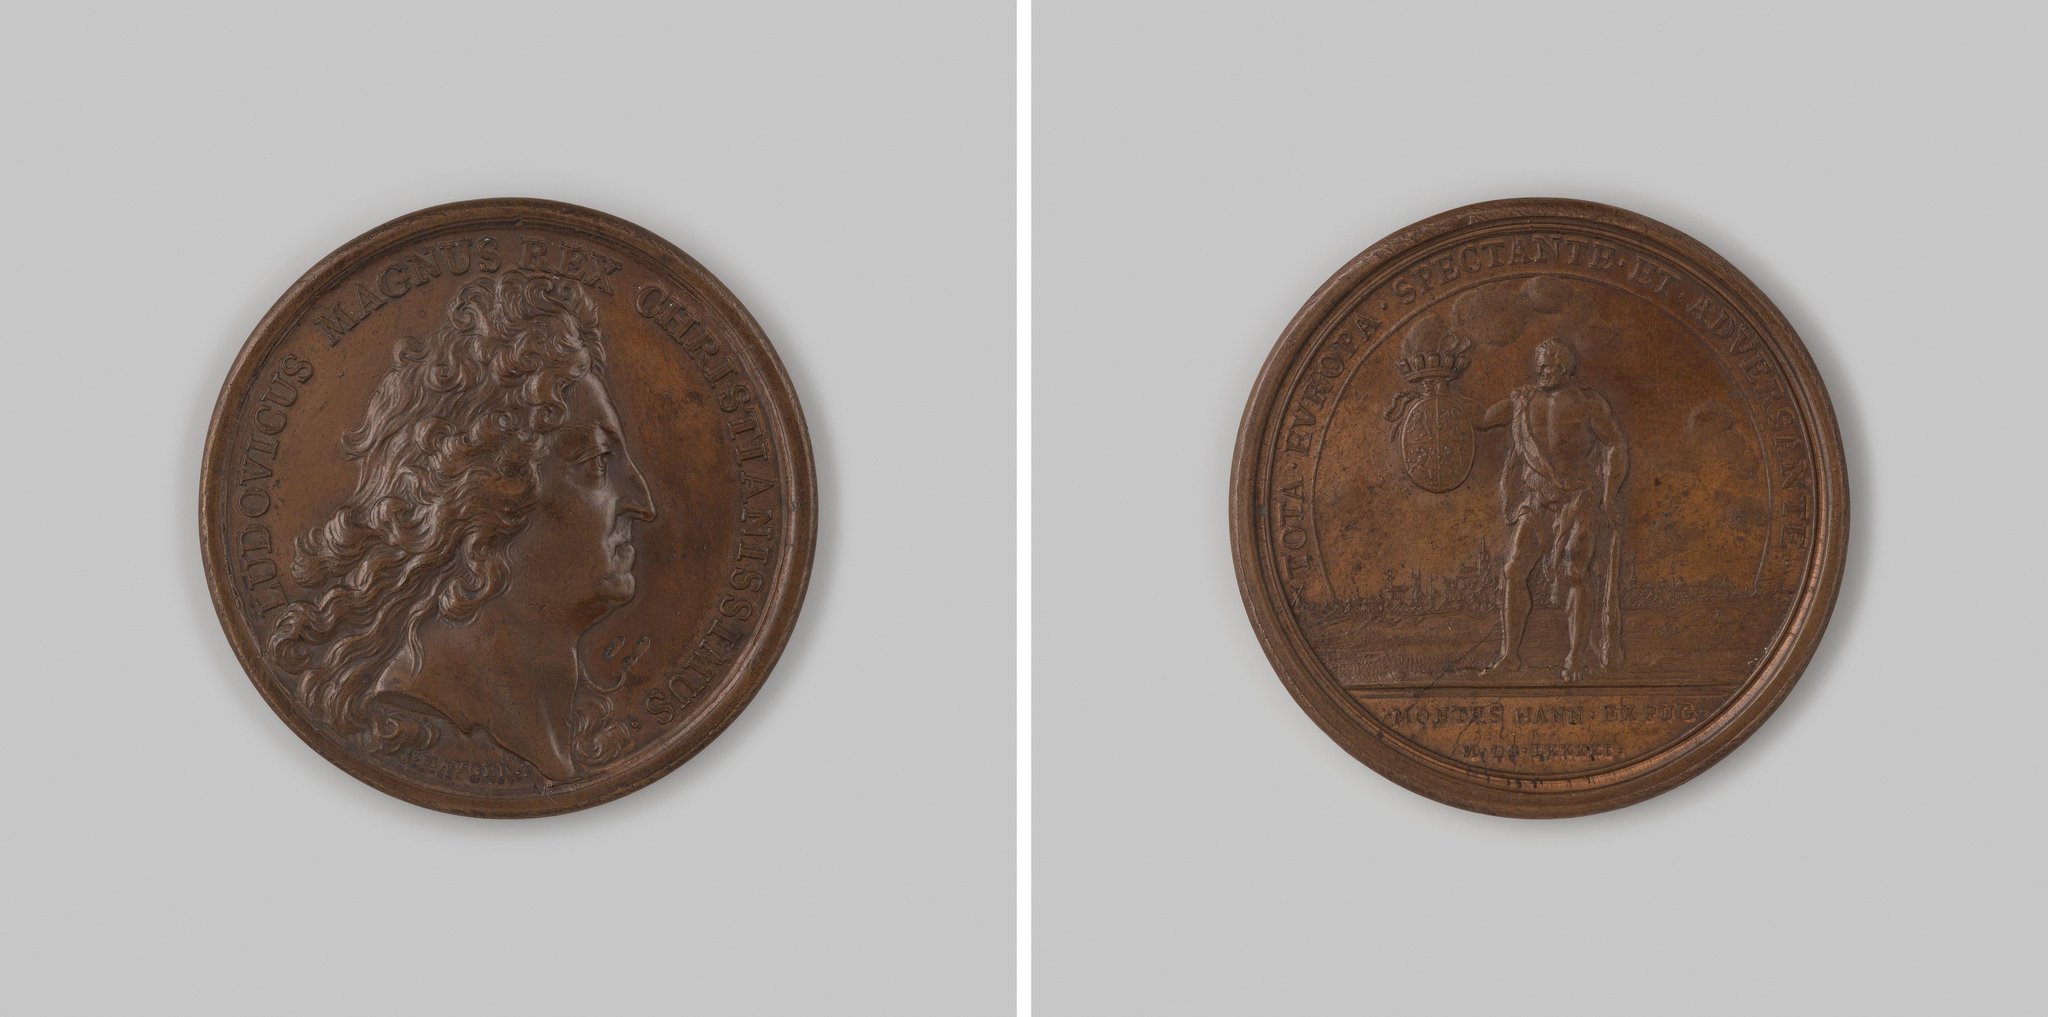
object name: history medal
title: Bergen in Henegouwen ingenomen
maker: jean mauger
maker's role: medailleur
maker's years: 1648-1722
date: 1699-1702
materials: bronze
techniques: striking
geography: paris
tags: lodewijk xiv (koning van frankrijk), henegouwen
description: Bronzen penning. Voorzijde: borststuk man binnen omschrift. Keerzijde: Hercules met knots houdt gekroond wapenschild van Bergen omhoog, op achtergrond gezicht op veroverde stad binnen omschrift; afsnede: opschrift